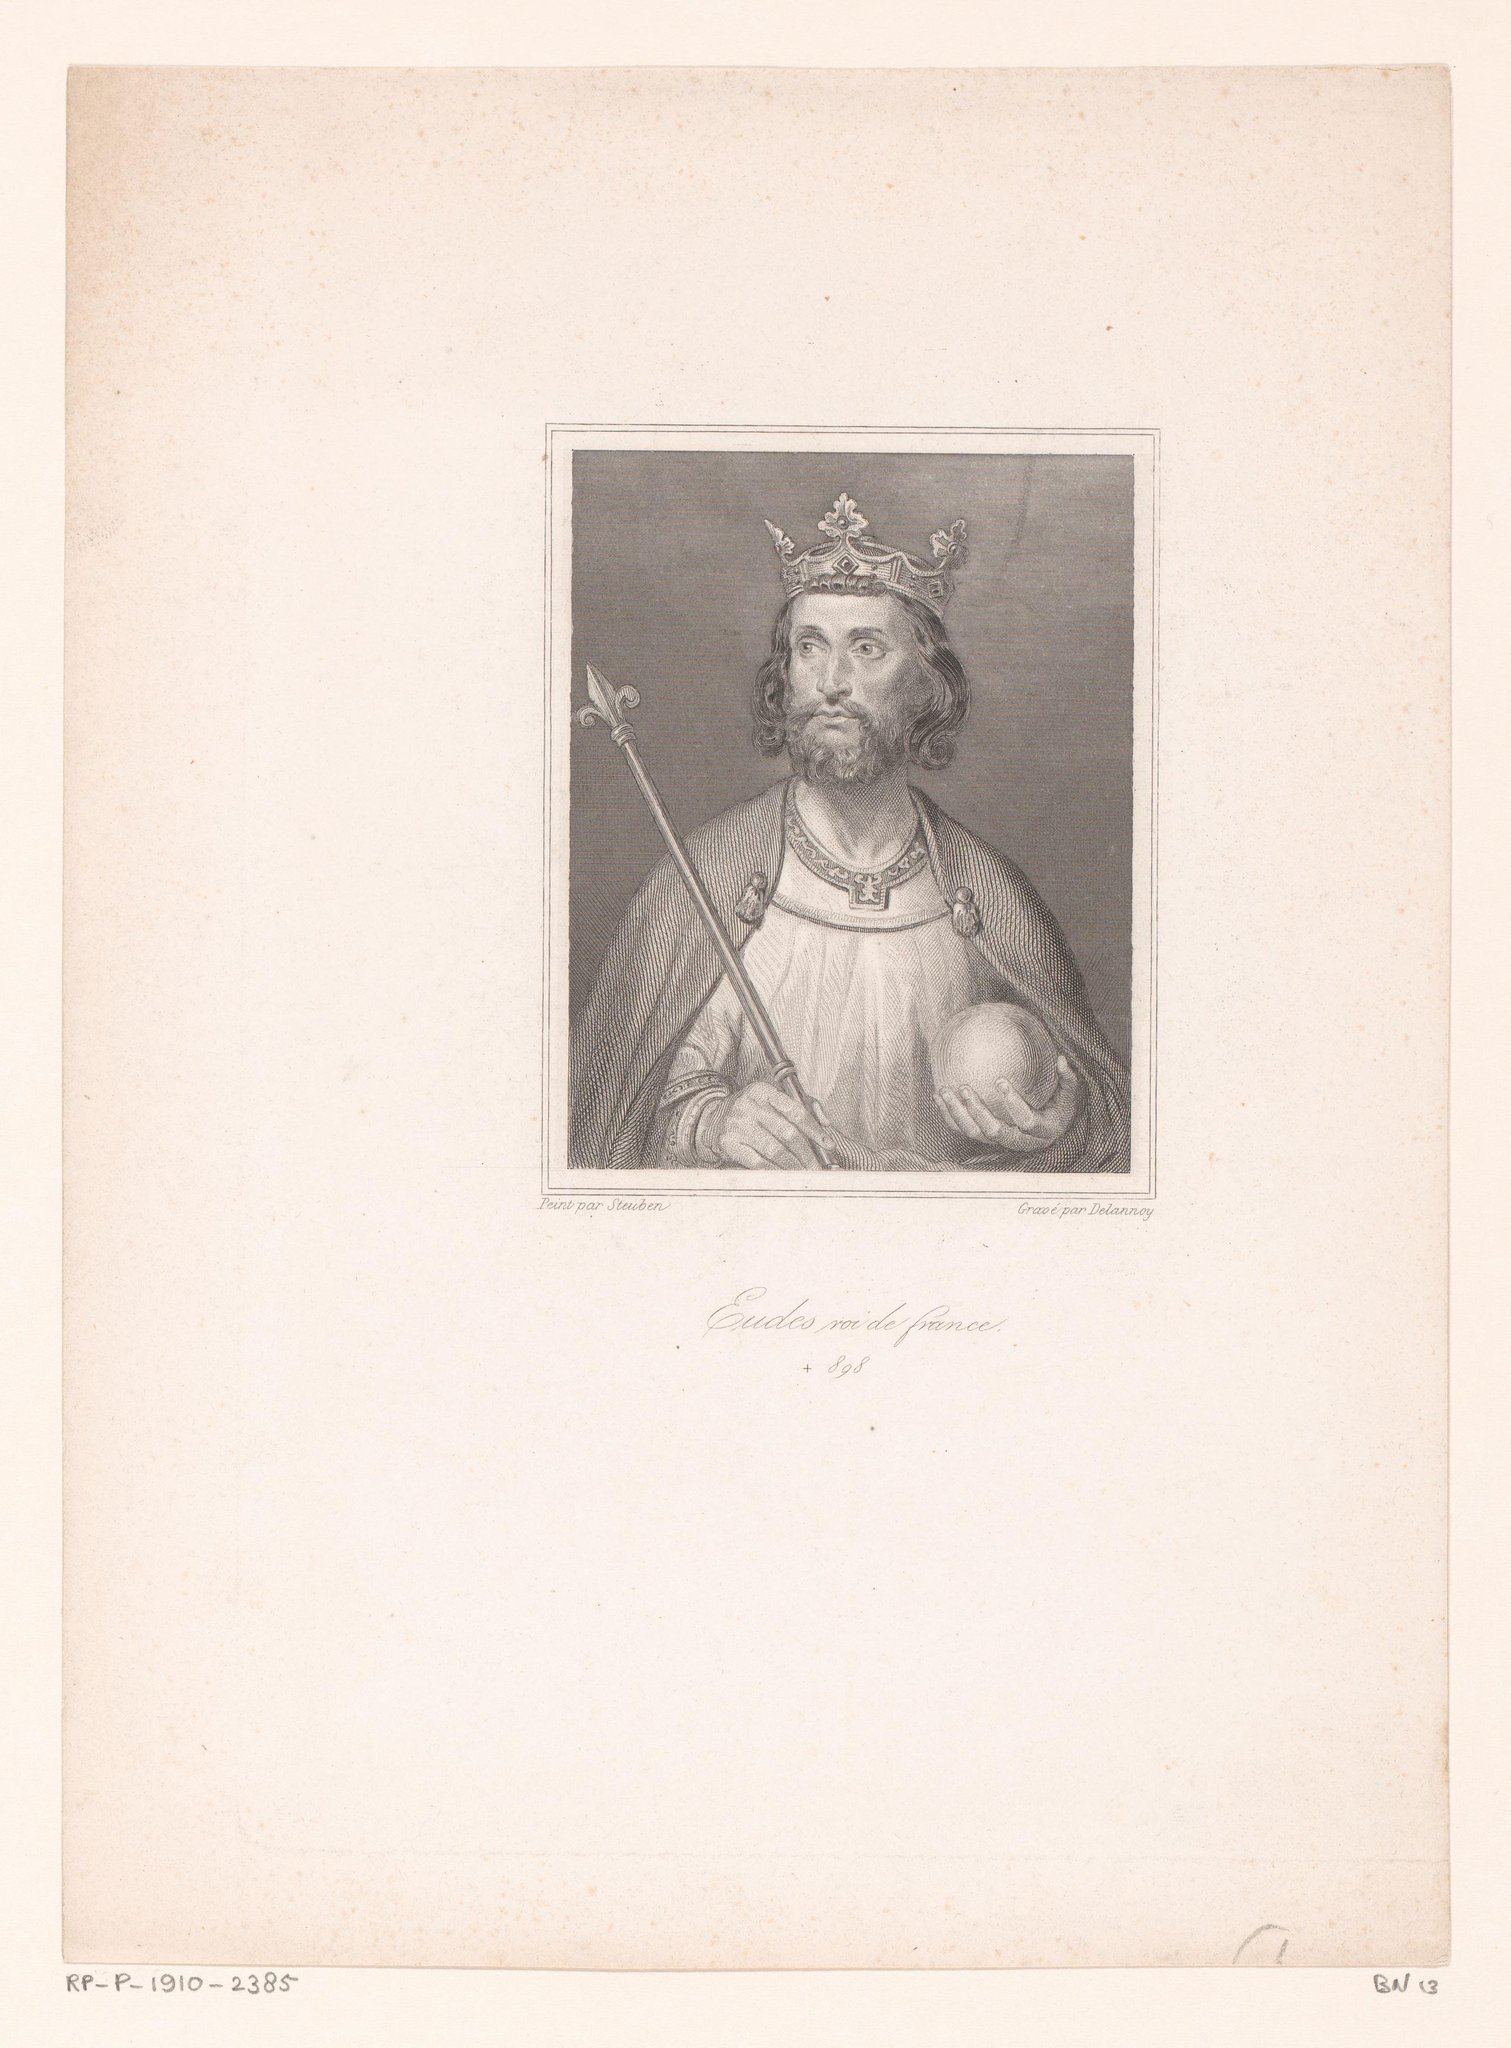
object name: book illustration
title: Portret van Odo I, koning van West-Francië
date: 1838-1841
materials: paper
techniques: engraving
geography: france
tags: historical persons, king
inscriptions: collector's mark: Lugt 2228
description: Prent uit: s.n. Galeries historiques de Versailles. Parijs: Charles Gavard, 1838-1841.